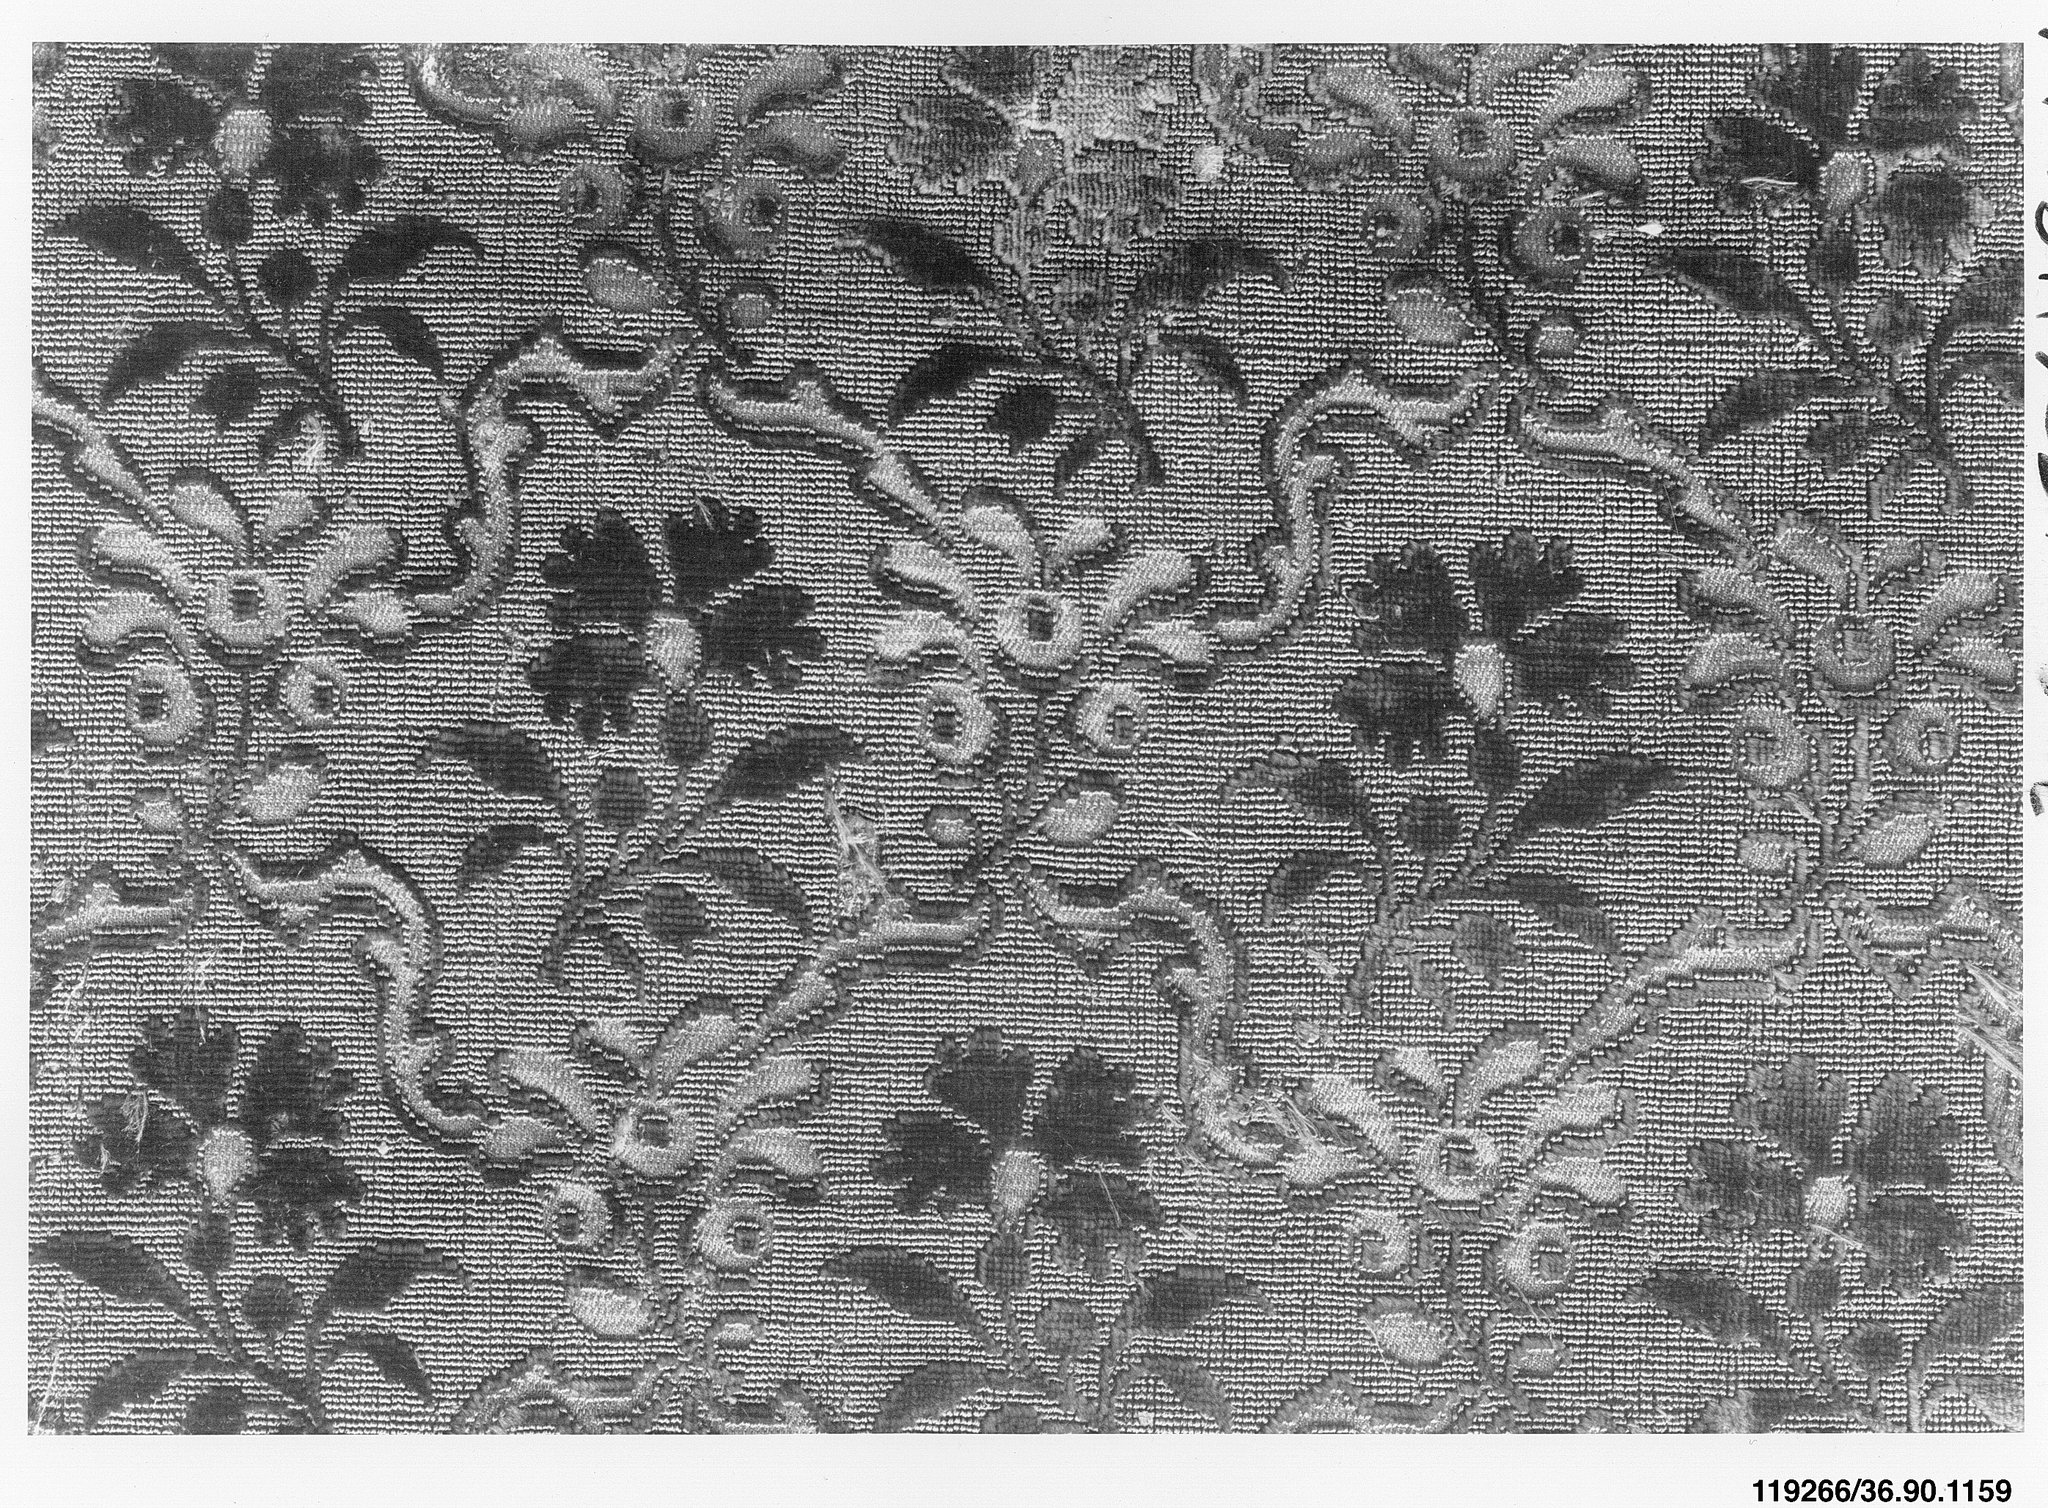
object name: piece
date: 1701-1800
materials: silk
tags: flowers,leaves